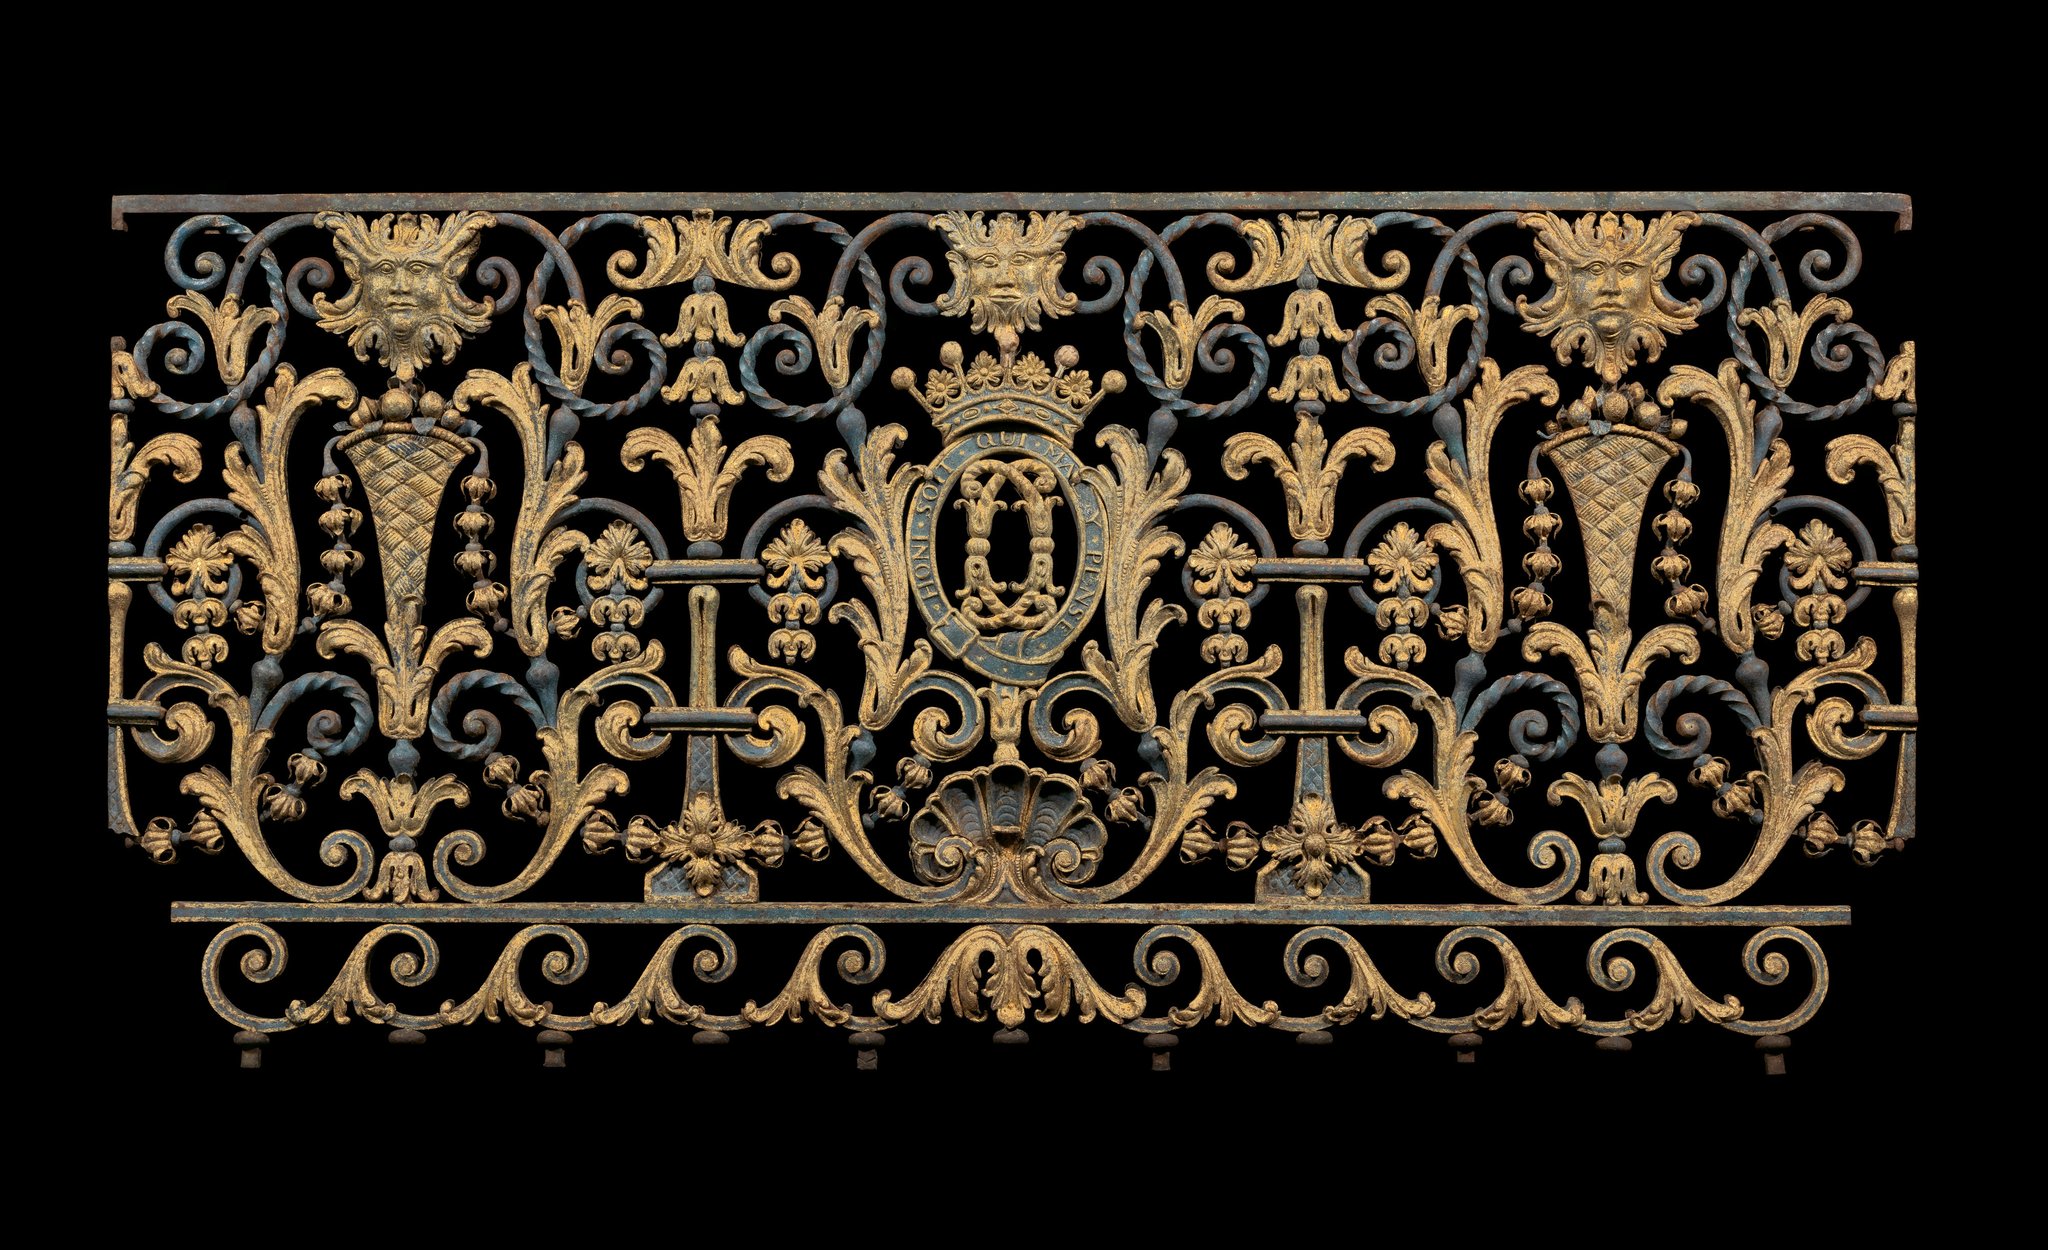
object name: staircase balustrade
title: Staircase balustrade from Chesterfield House, London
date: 1747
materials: pigment, iron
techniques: gilding